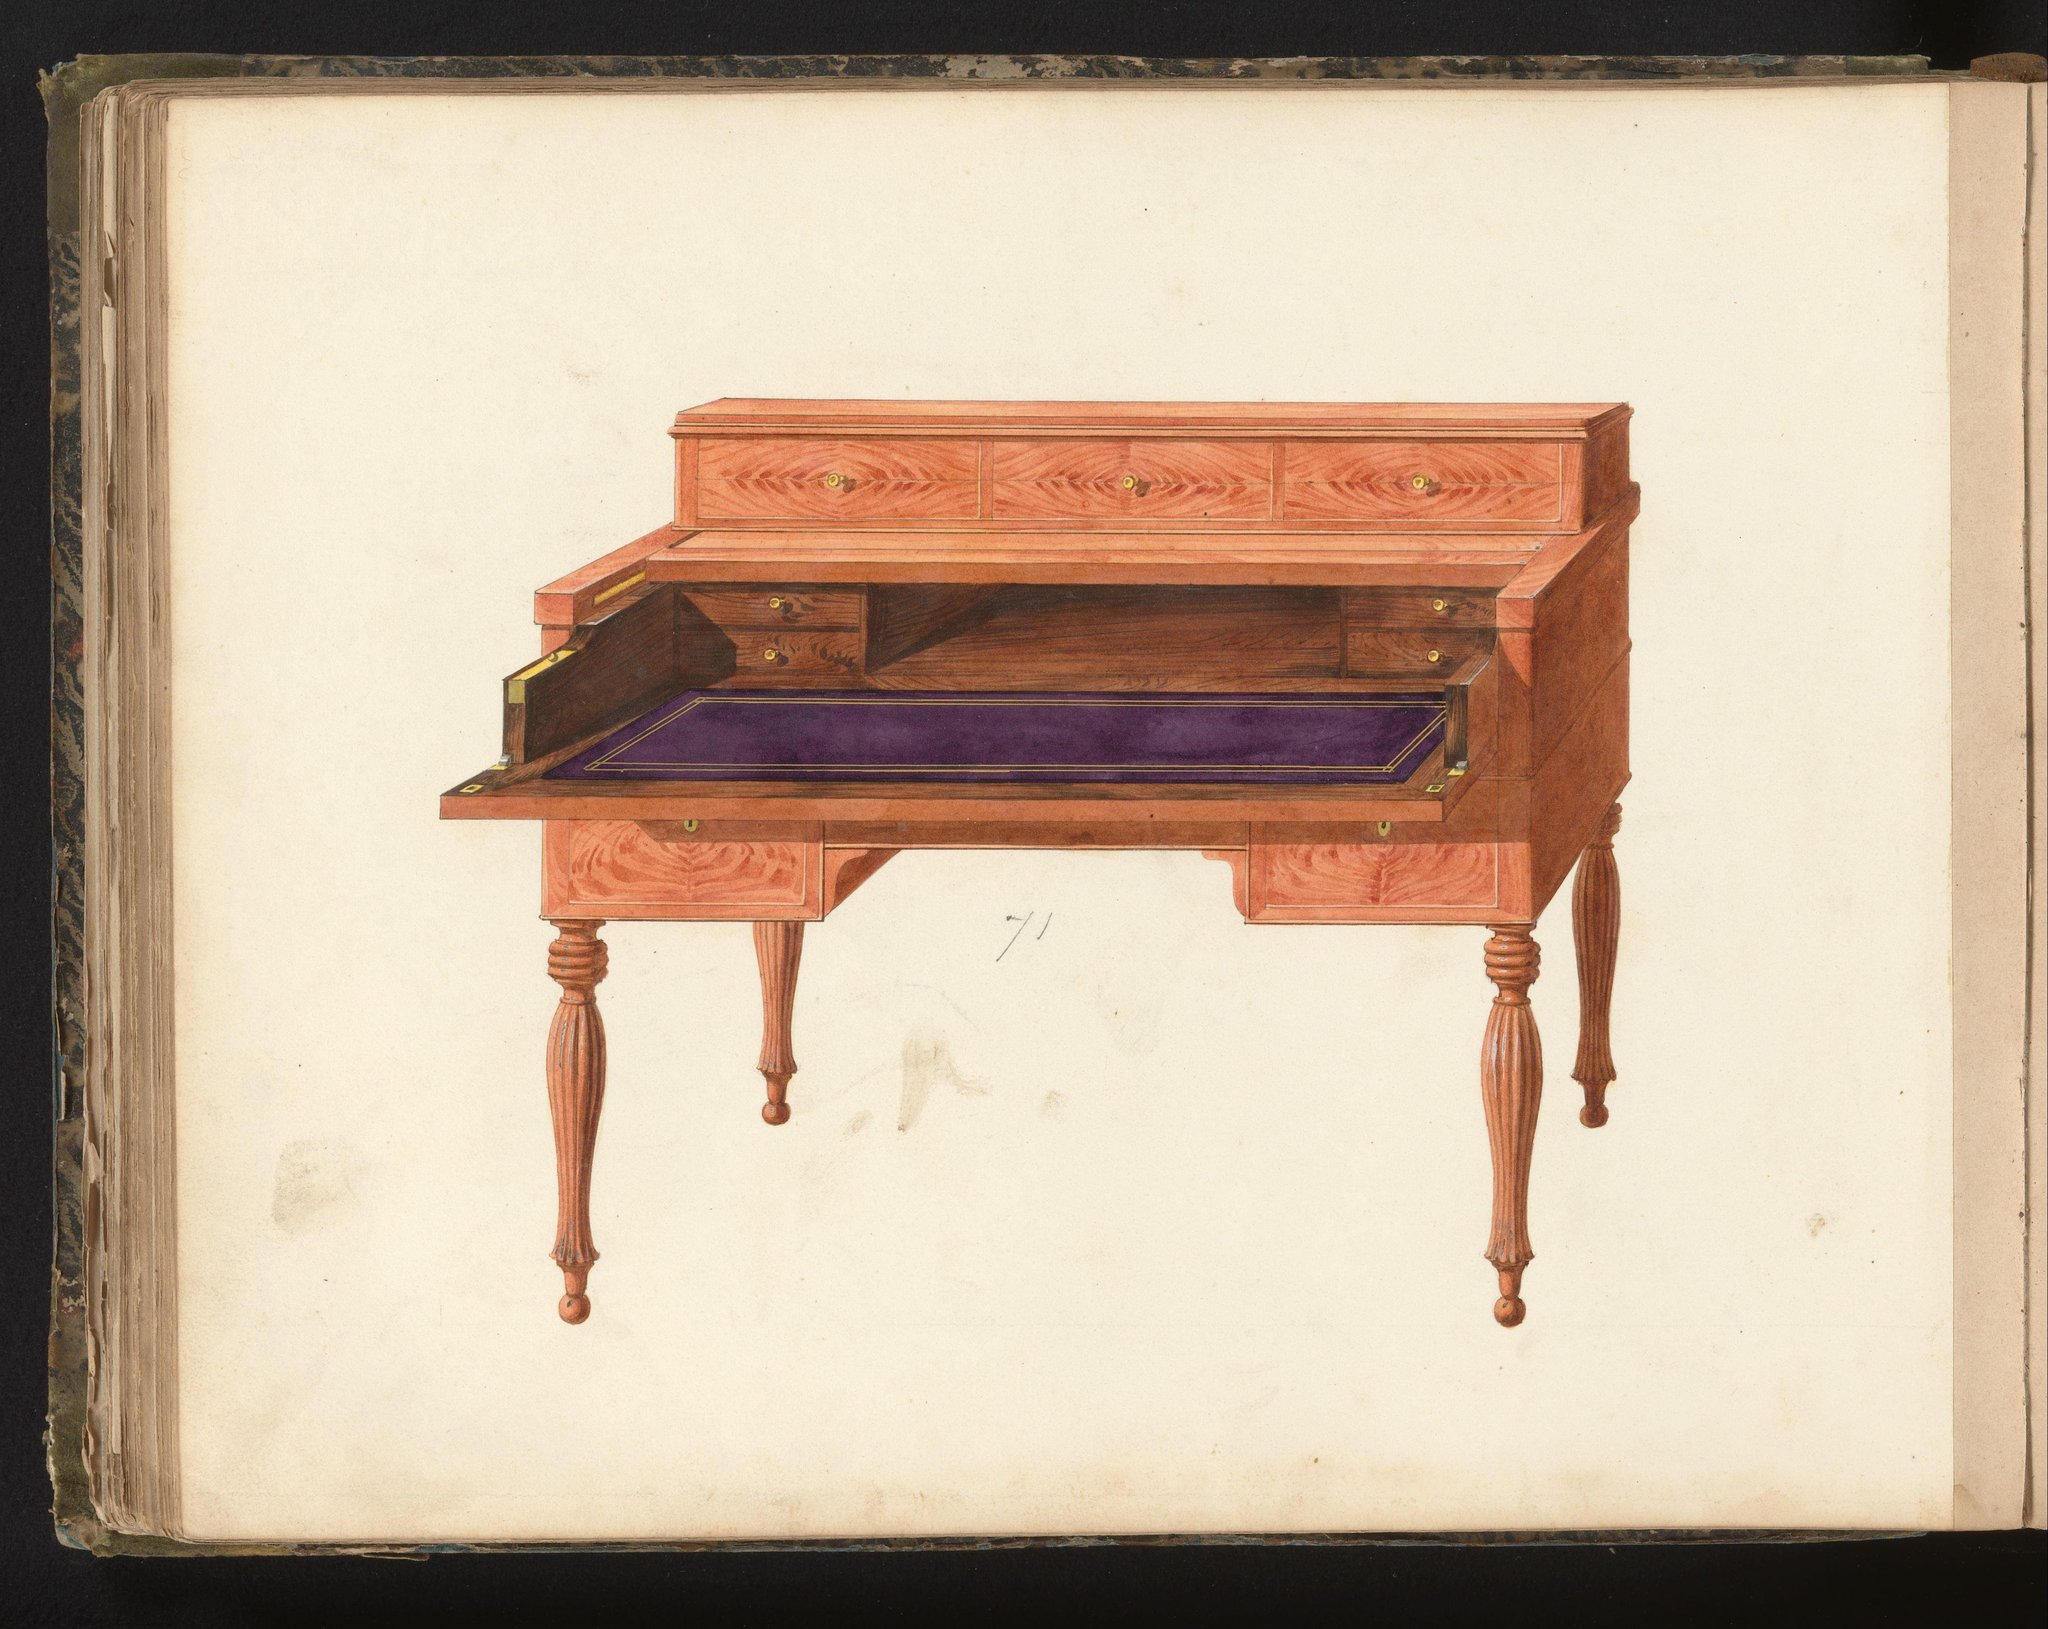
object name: drawing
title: Ontwerp voor een ‘piano-bureau’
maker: Anonymous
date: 1825-1839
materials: ink, paper, pencil, watercolor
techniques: brush, pen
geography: paris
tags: writing-table, writing-desk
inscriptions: inscription: ‘71 Bureau piano 3½ 4 4½ Bureau à cylendre 4 4½ 5’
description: Ontwerp voor zogenaamd ‘piano-bureau’ met klep en drie lades in het opstel. Het blad op de achterzijde genummerd: 65, het tegenoverliggende blad met informatie over de afgebeelde meubelen genummerd: 65 bis. Onderdeel van een album met 80 bladen met tekeningen en een prent van gefineerde en gelakte meubelen, alsmede zitmeubelen.